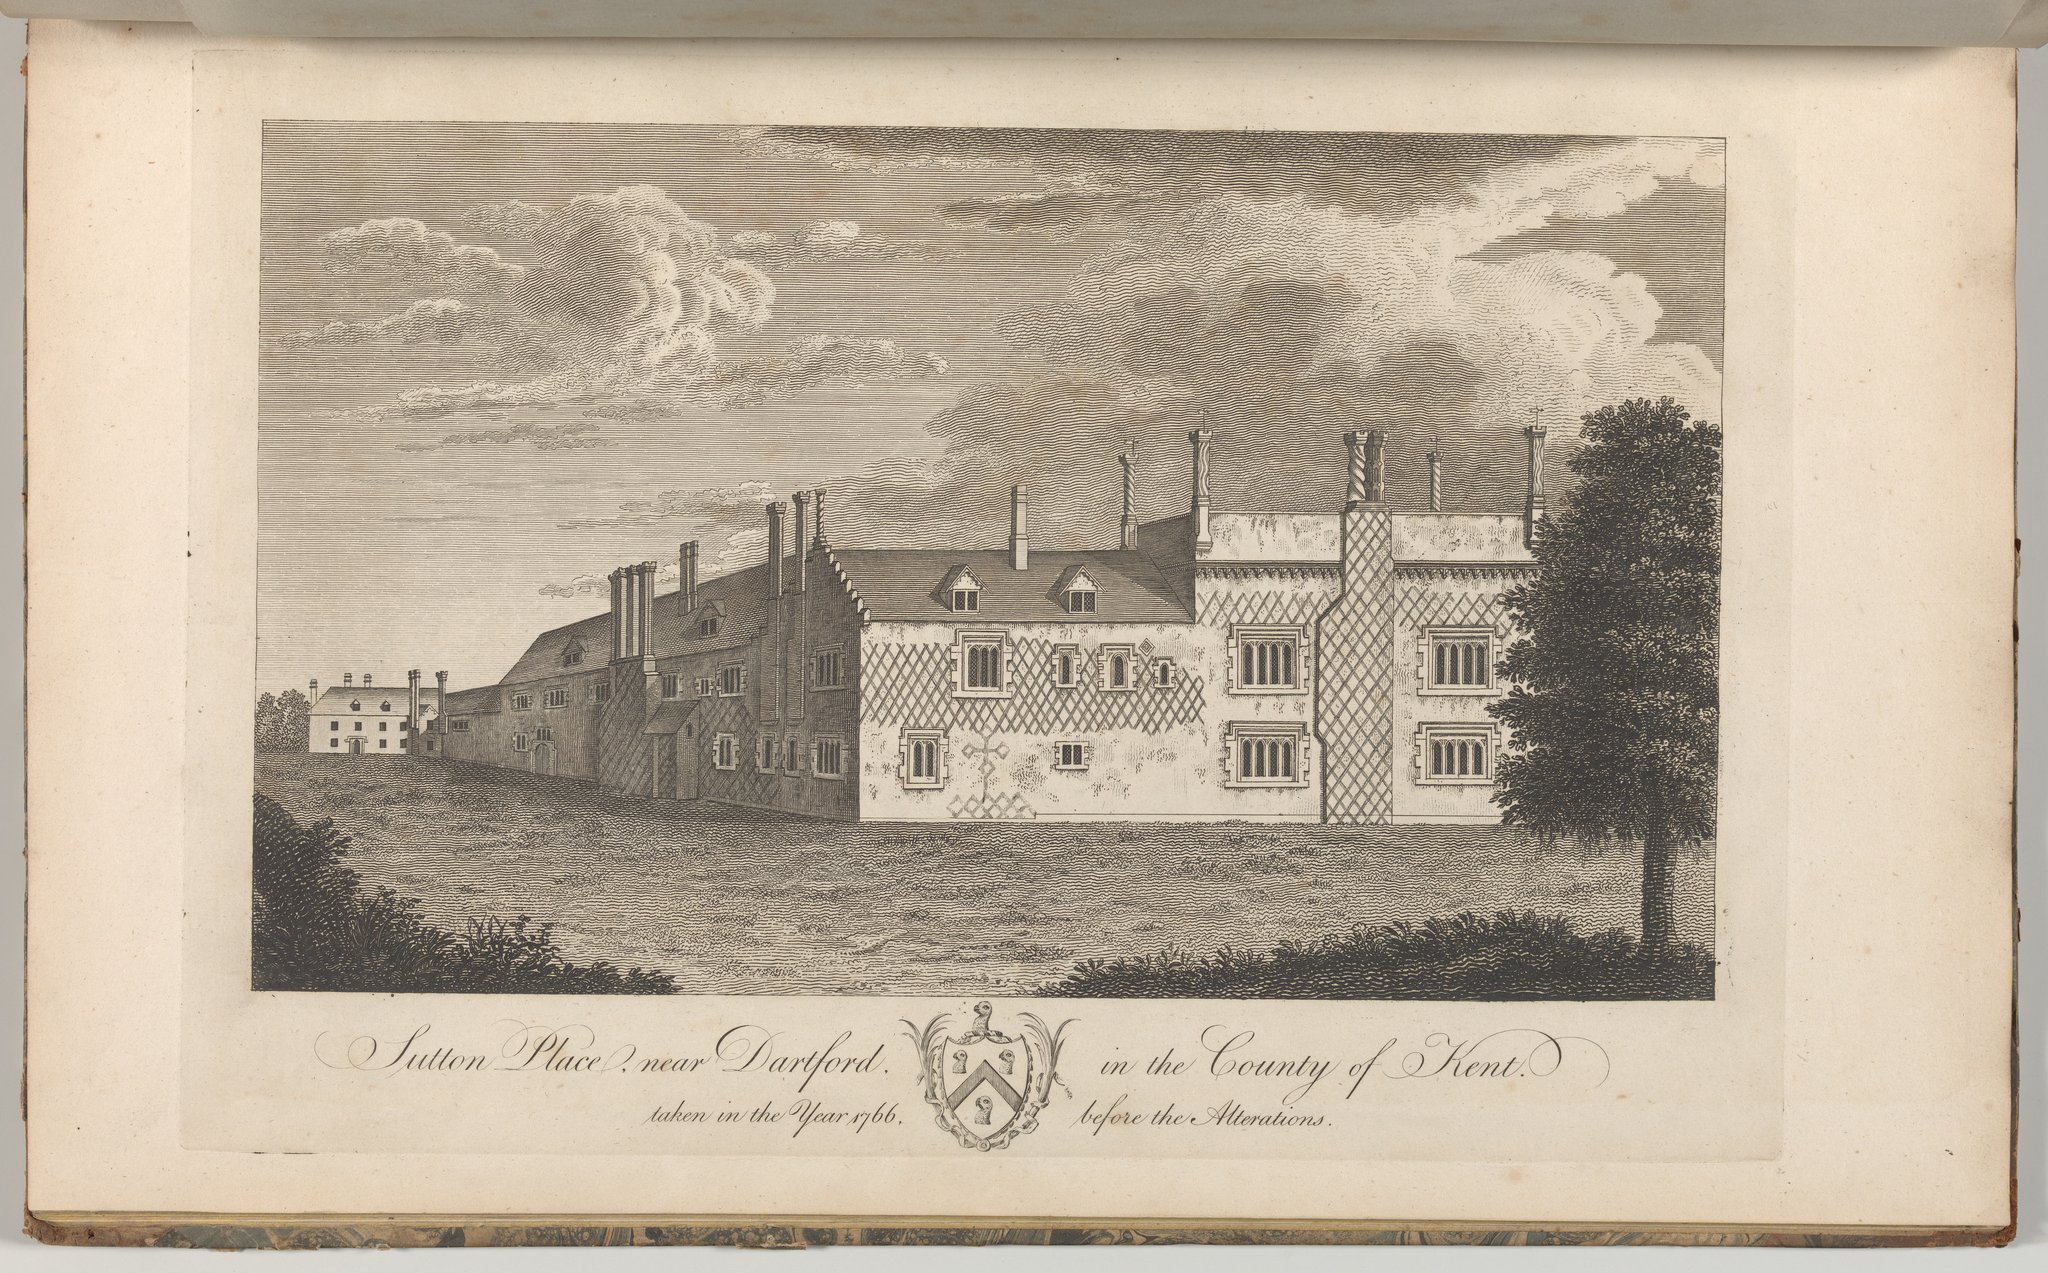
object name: print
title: Sutton Place, near Dartford, in the County of Kent, taken in the year 1766, before the alterations, from Edward Hasted's "The History and Topographical Survey of the County of Kent", vols. 1-3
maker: anonymous, british, 18th century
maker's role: artist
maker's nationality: british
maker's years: 1700-1800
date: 1777-1790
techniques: engraving, etching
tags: buildings,coat of arms